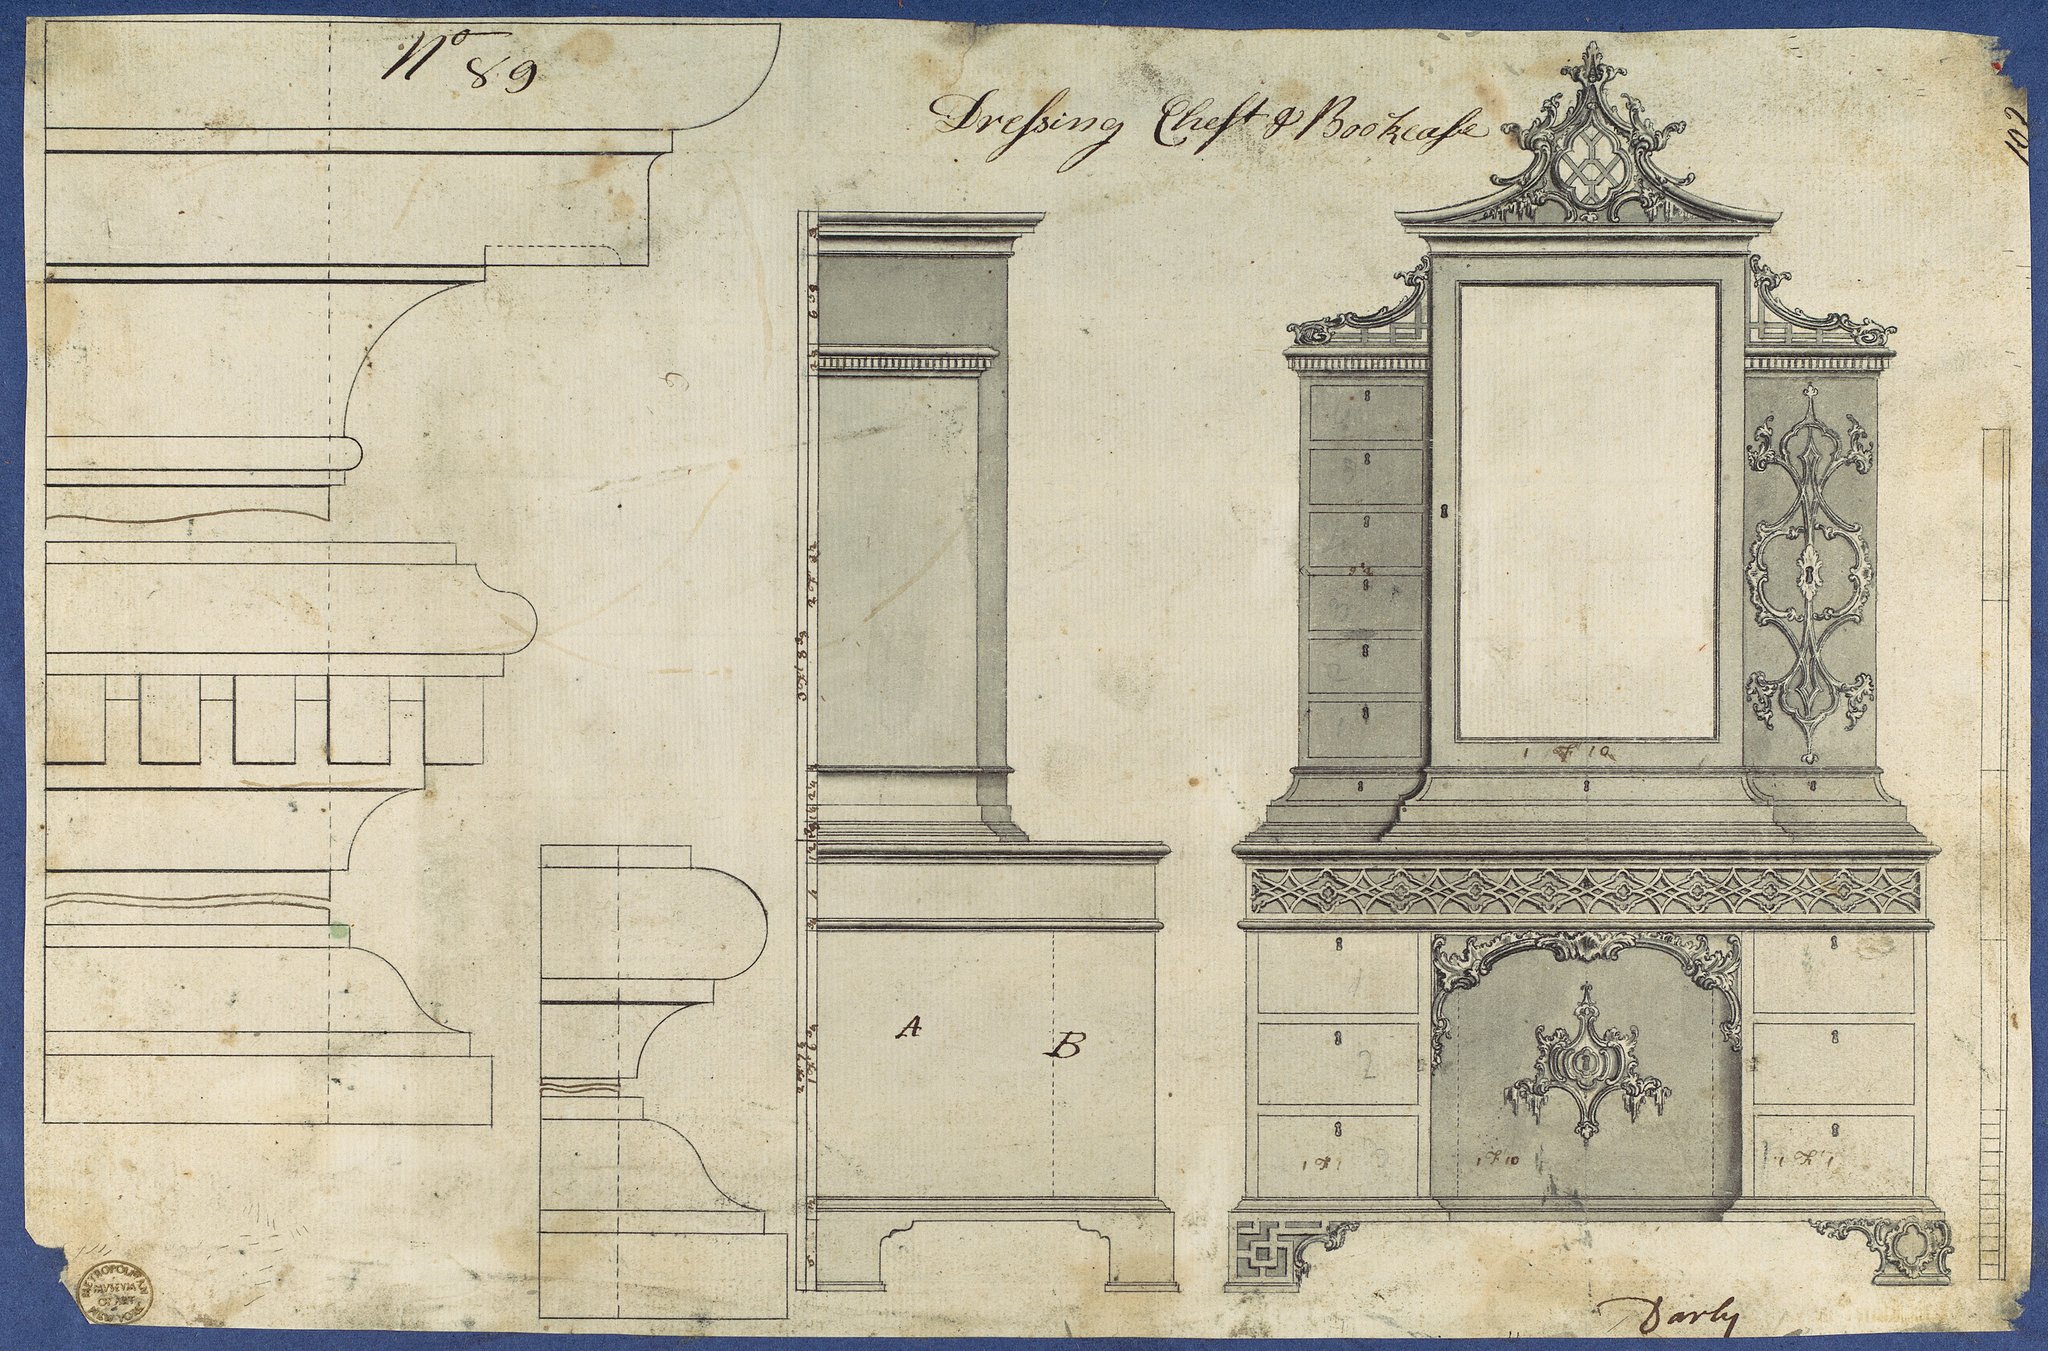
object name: drawing ornament architecture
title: Dressing Chest and Bookcase, from Chippendale Drawings, Vol. II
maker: thomas chippendale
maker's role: artist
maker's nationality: british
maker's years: 1718-1779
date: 1753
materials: ink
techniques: wash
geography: london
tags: chests